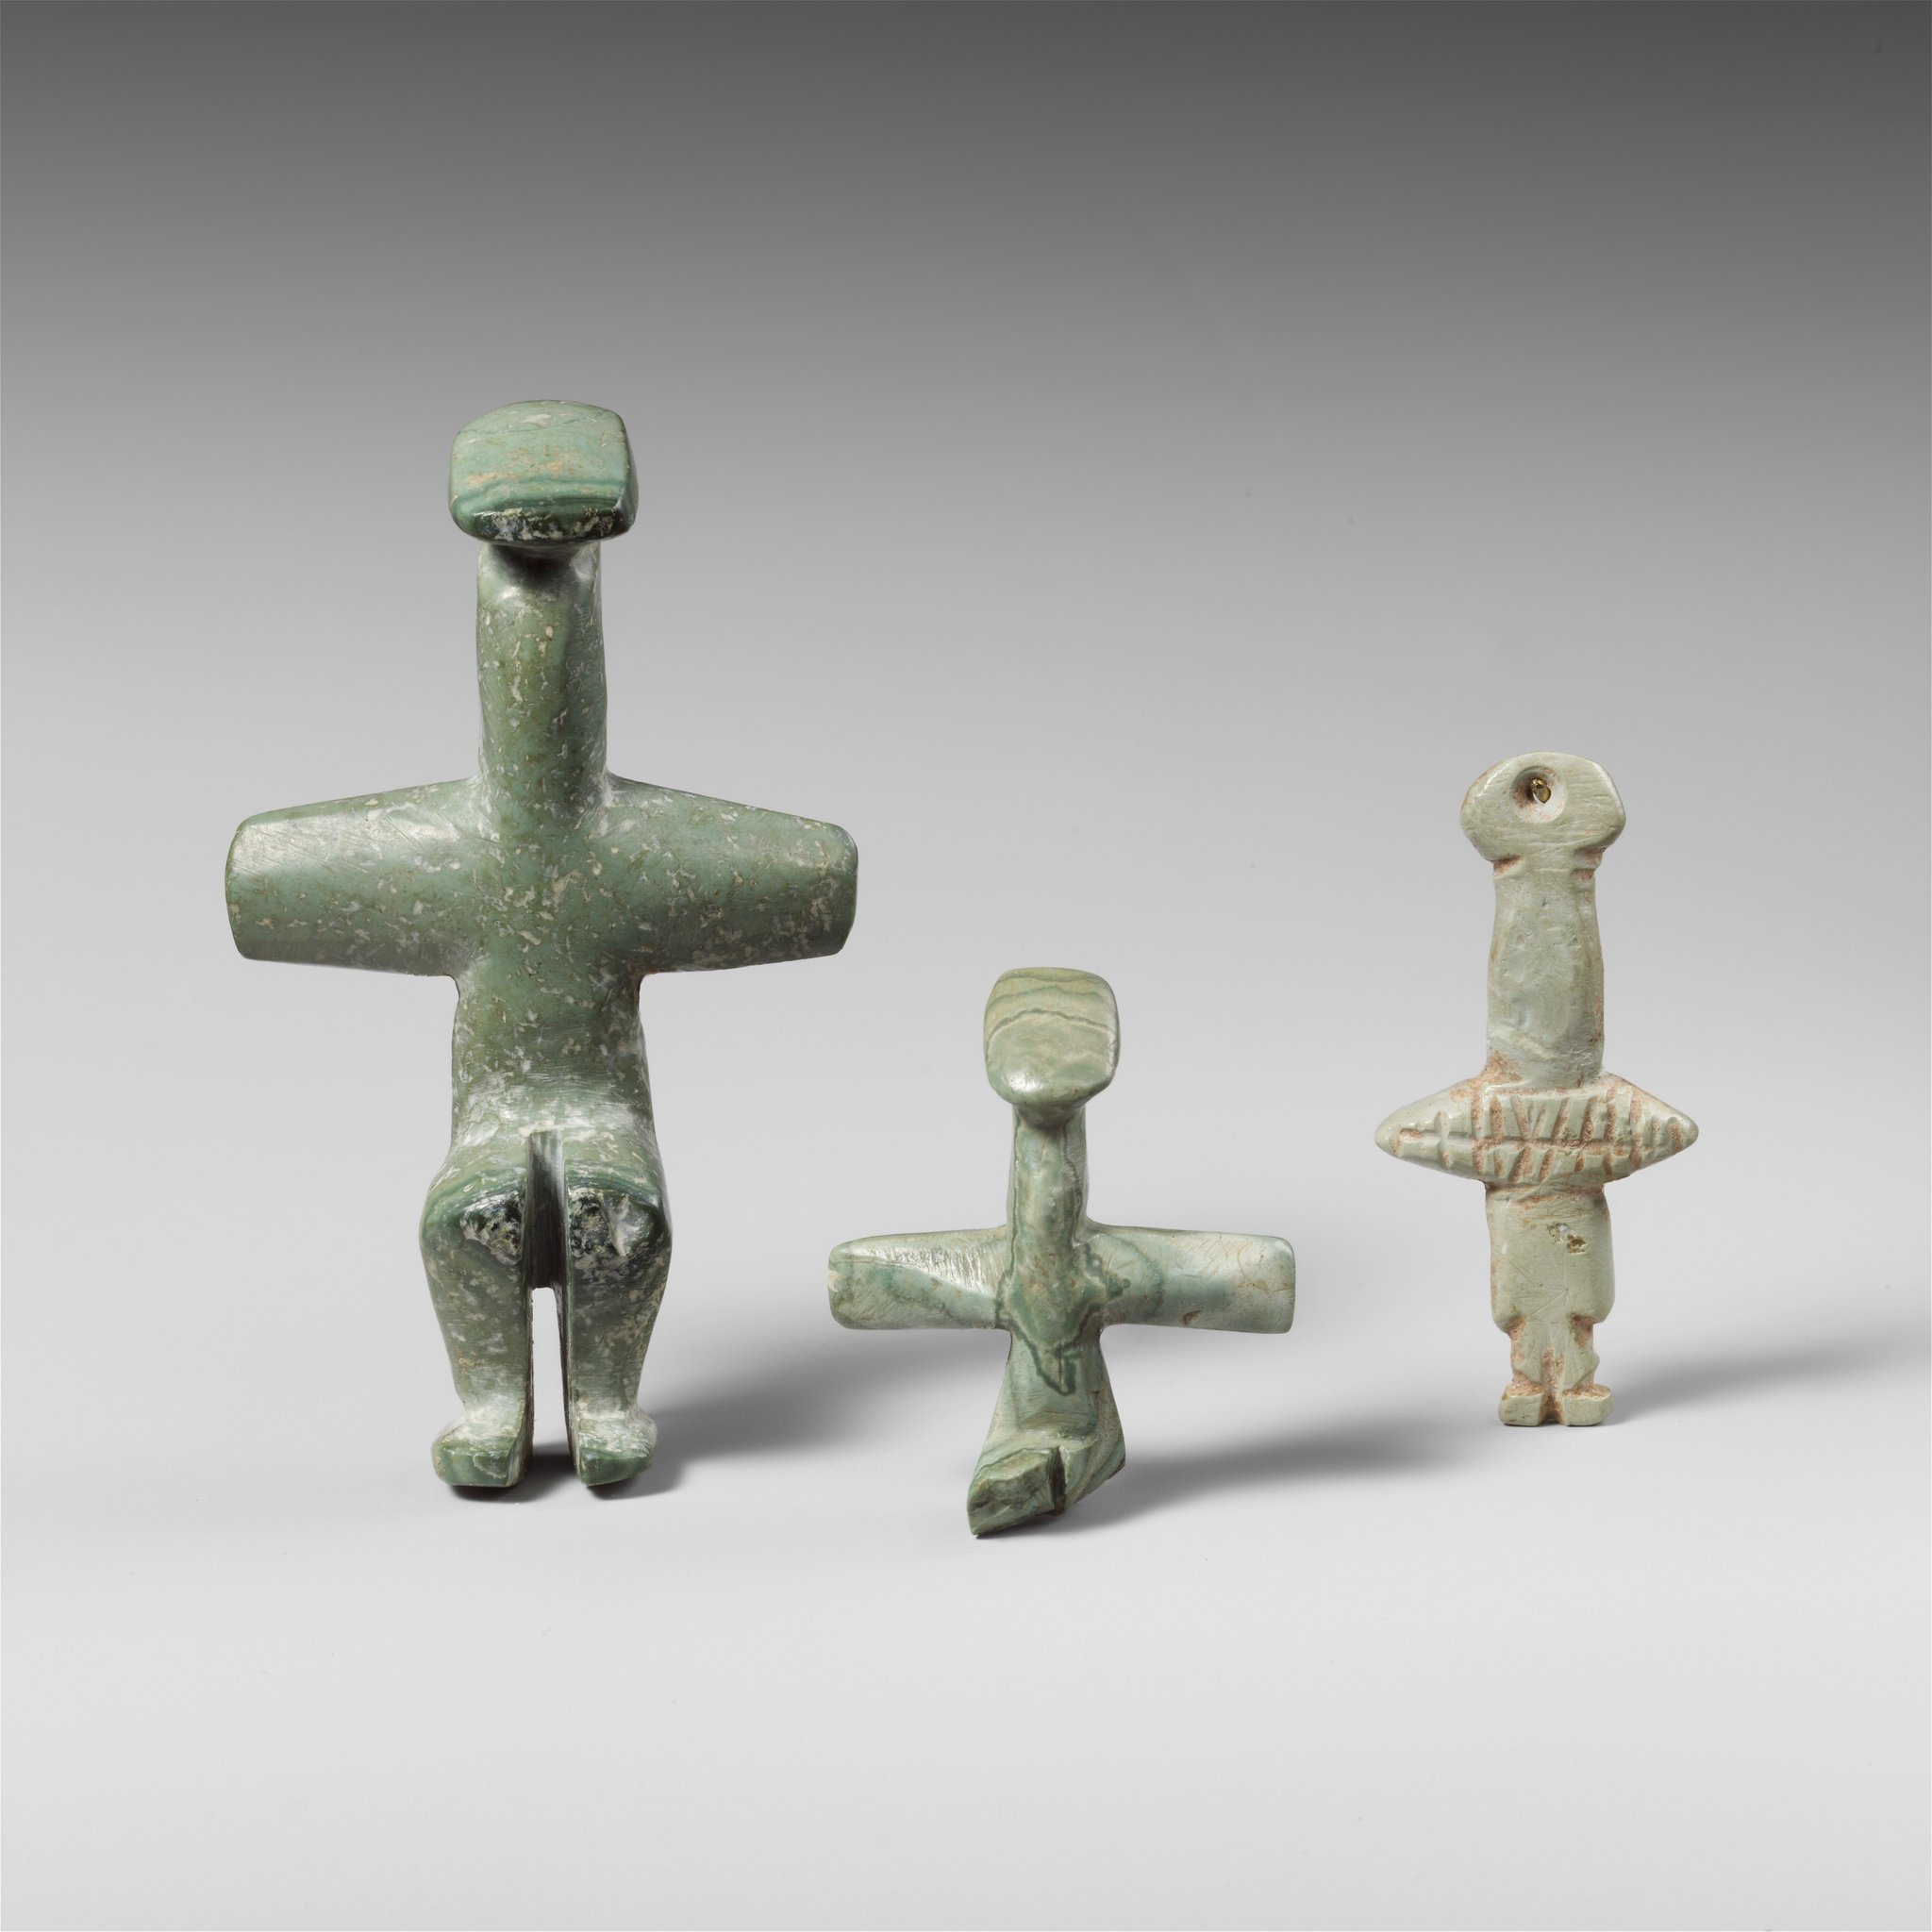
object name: figure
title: Picrolite figure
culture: cypriot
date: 3900-2500 BCE